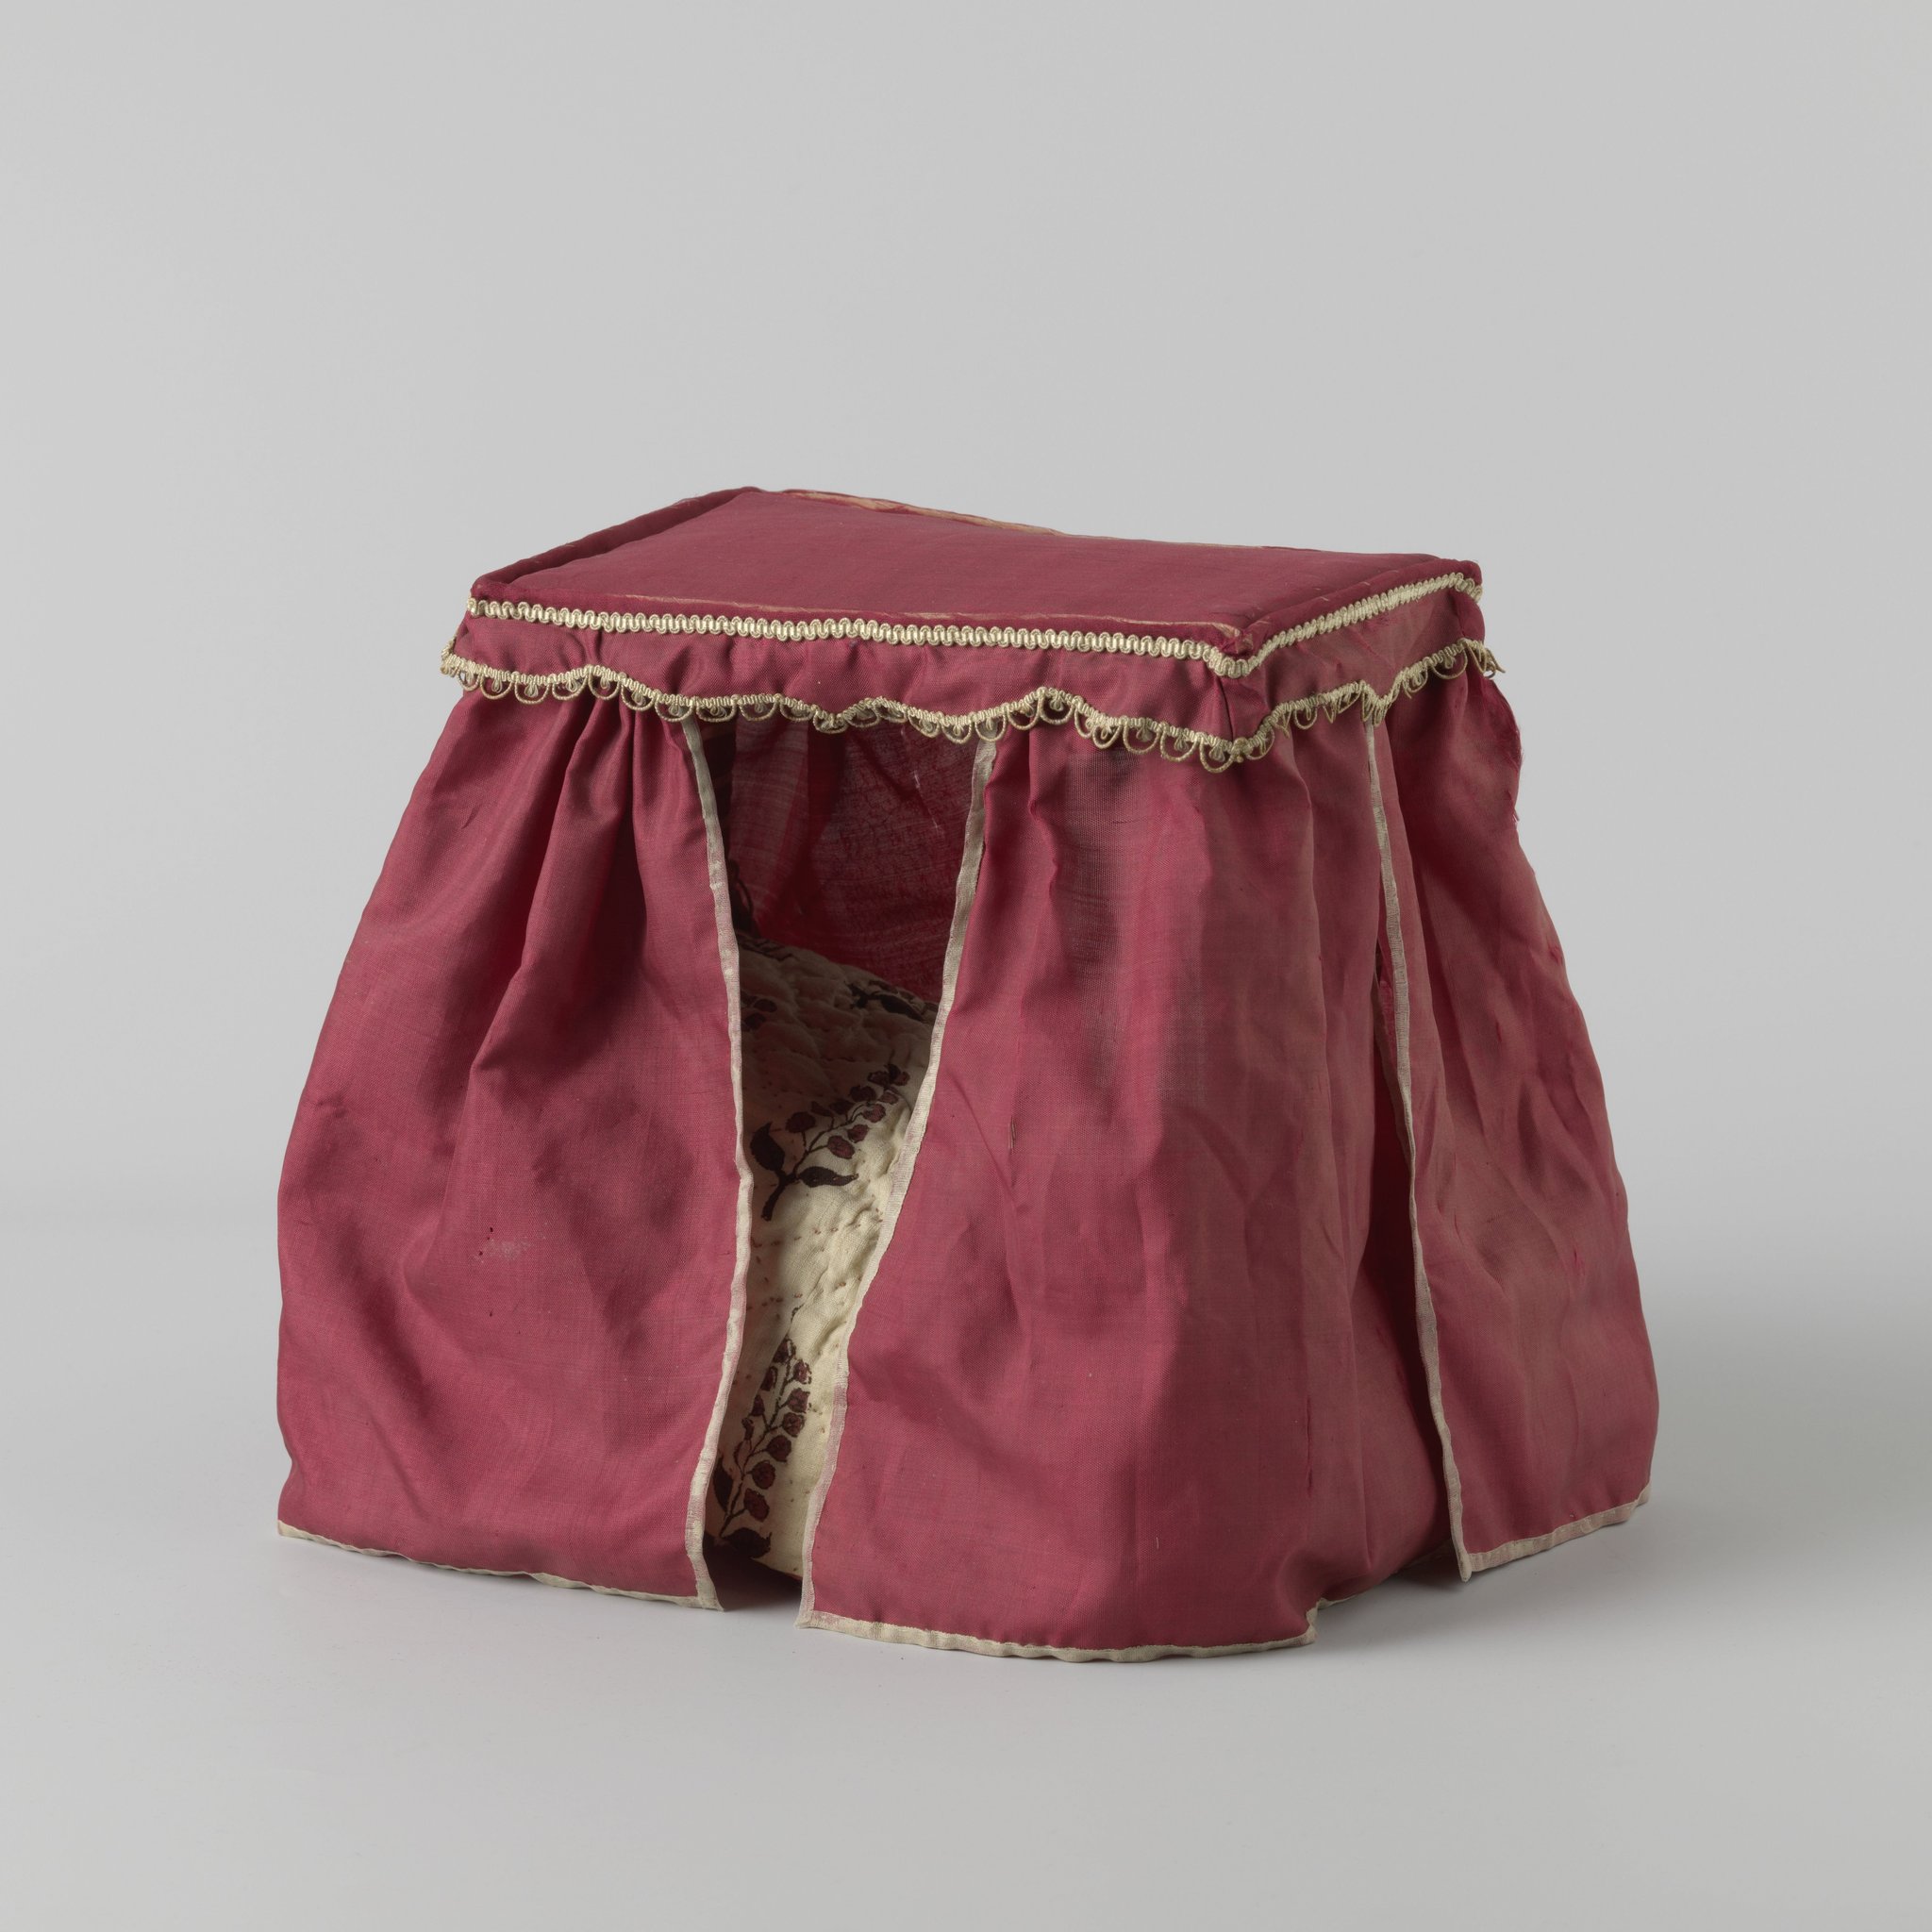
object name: furniture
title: Meubilair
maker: Anonymous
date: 1700-1800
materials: silk, wood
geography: northern netherlands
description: Ledikant met matras, twee kussens en twee gestikte zijden dekens, voorzien van rood zijden gordijnen, afgezet met passement.